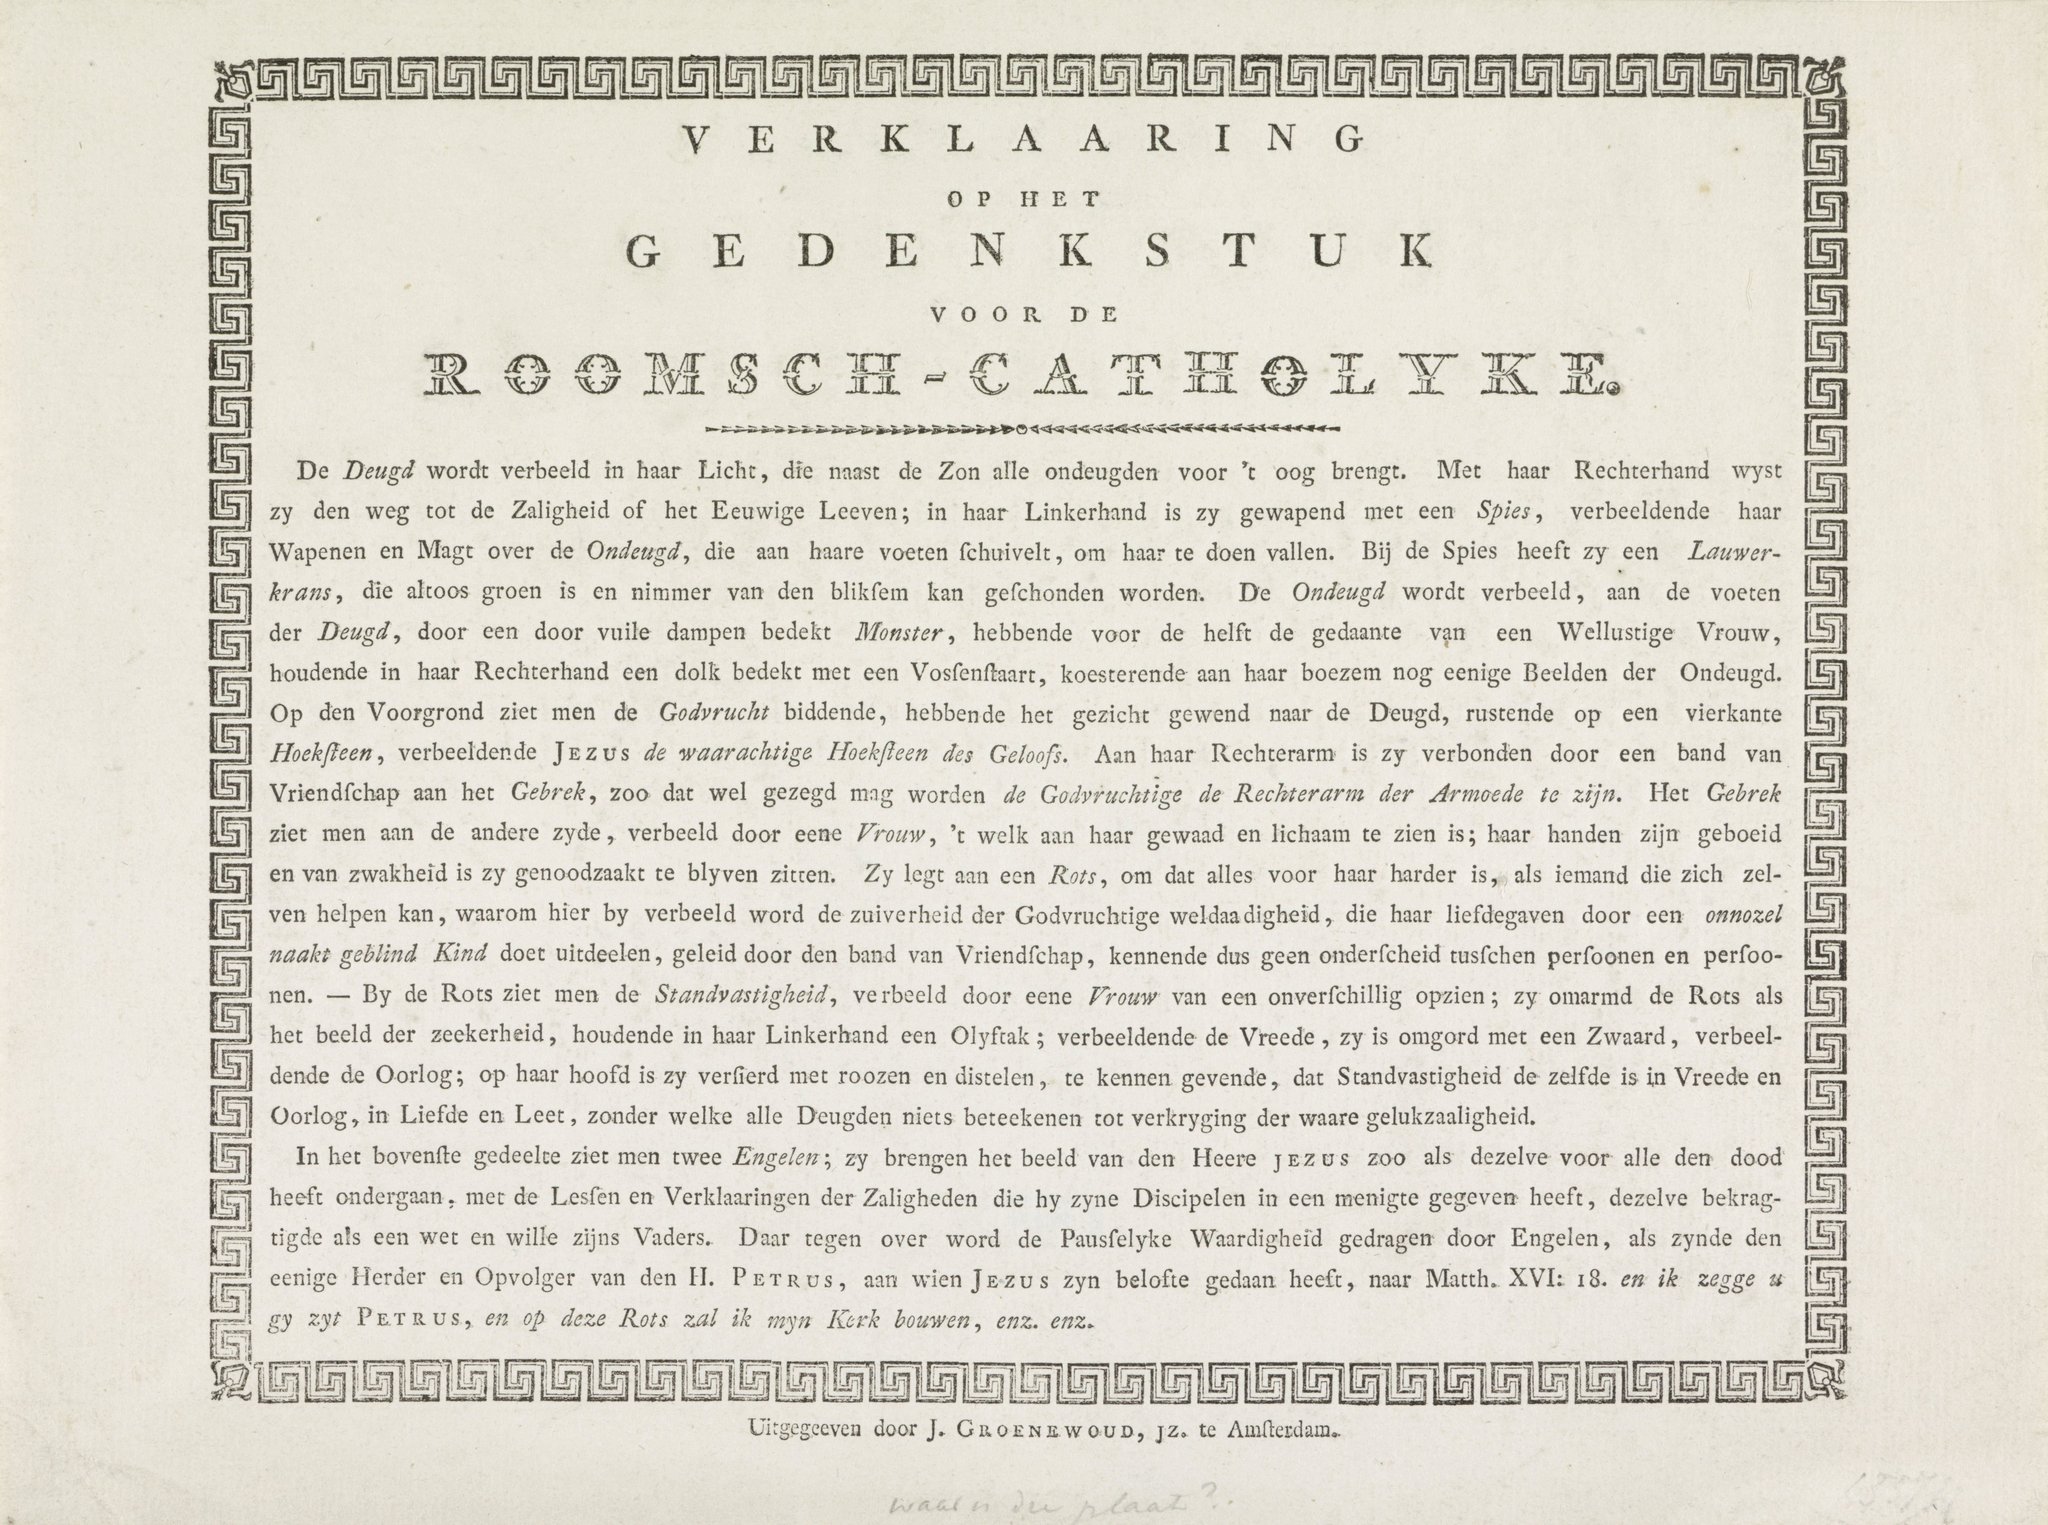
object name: print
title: Verklaaring op het Gedenkstuk voor de Roomsch-Catholyke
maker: johannes groenewoud jansz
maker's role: publisher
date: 1790-1810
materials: paper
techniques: letterpress printing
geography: amsterdam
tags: rooms katholieke kerk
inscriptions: collector's mark: Lugt 2228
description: Verklaring behorende bij de prent Gedenkstuk voor de Rooms-katholieke, ca. 1800. Tekst binnen een ornamentale rand.